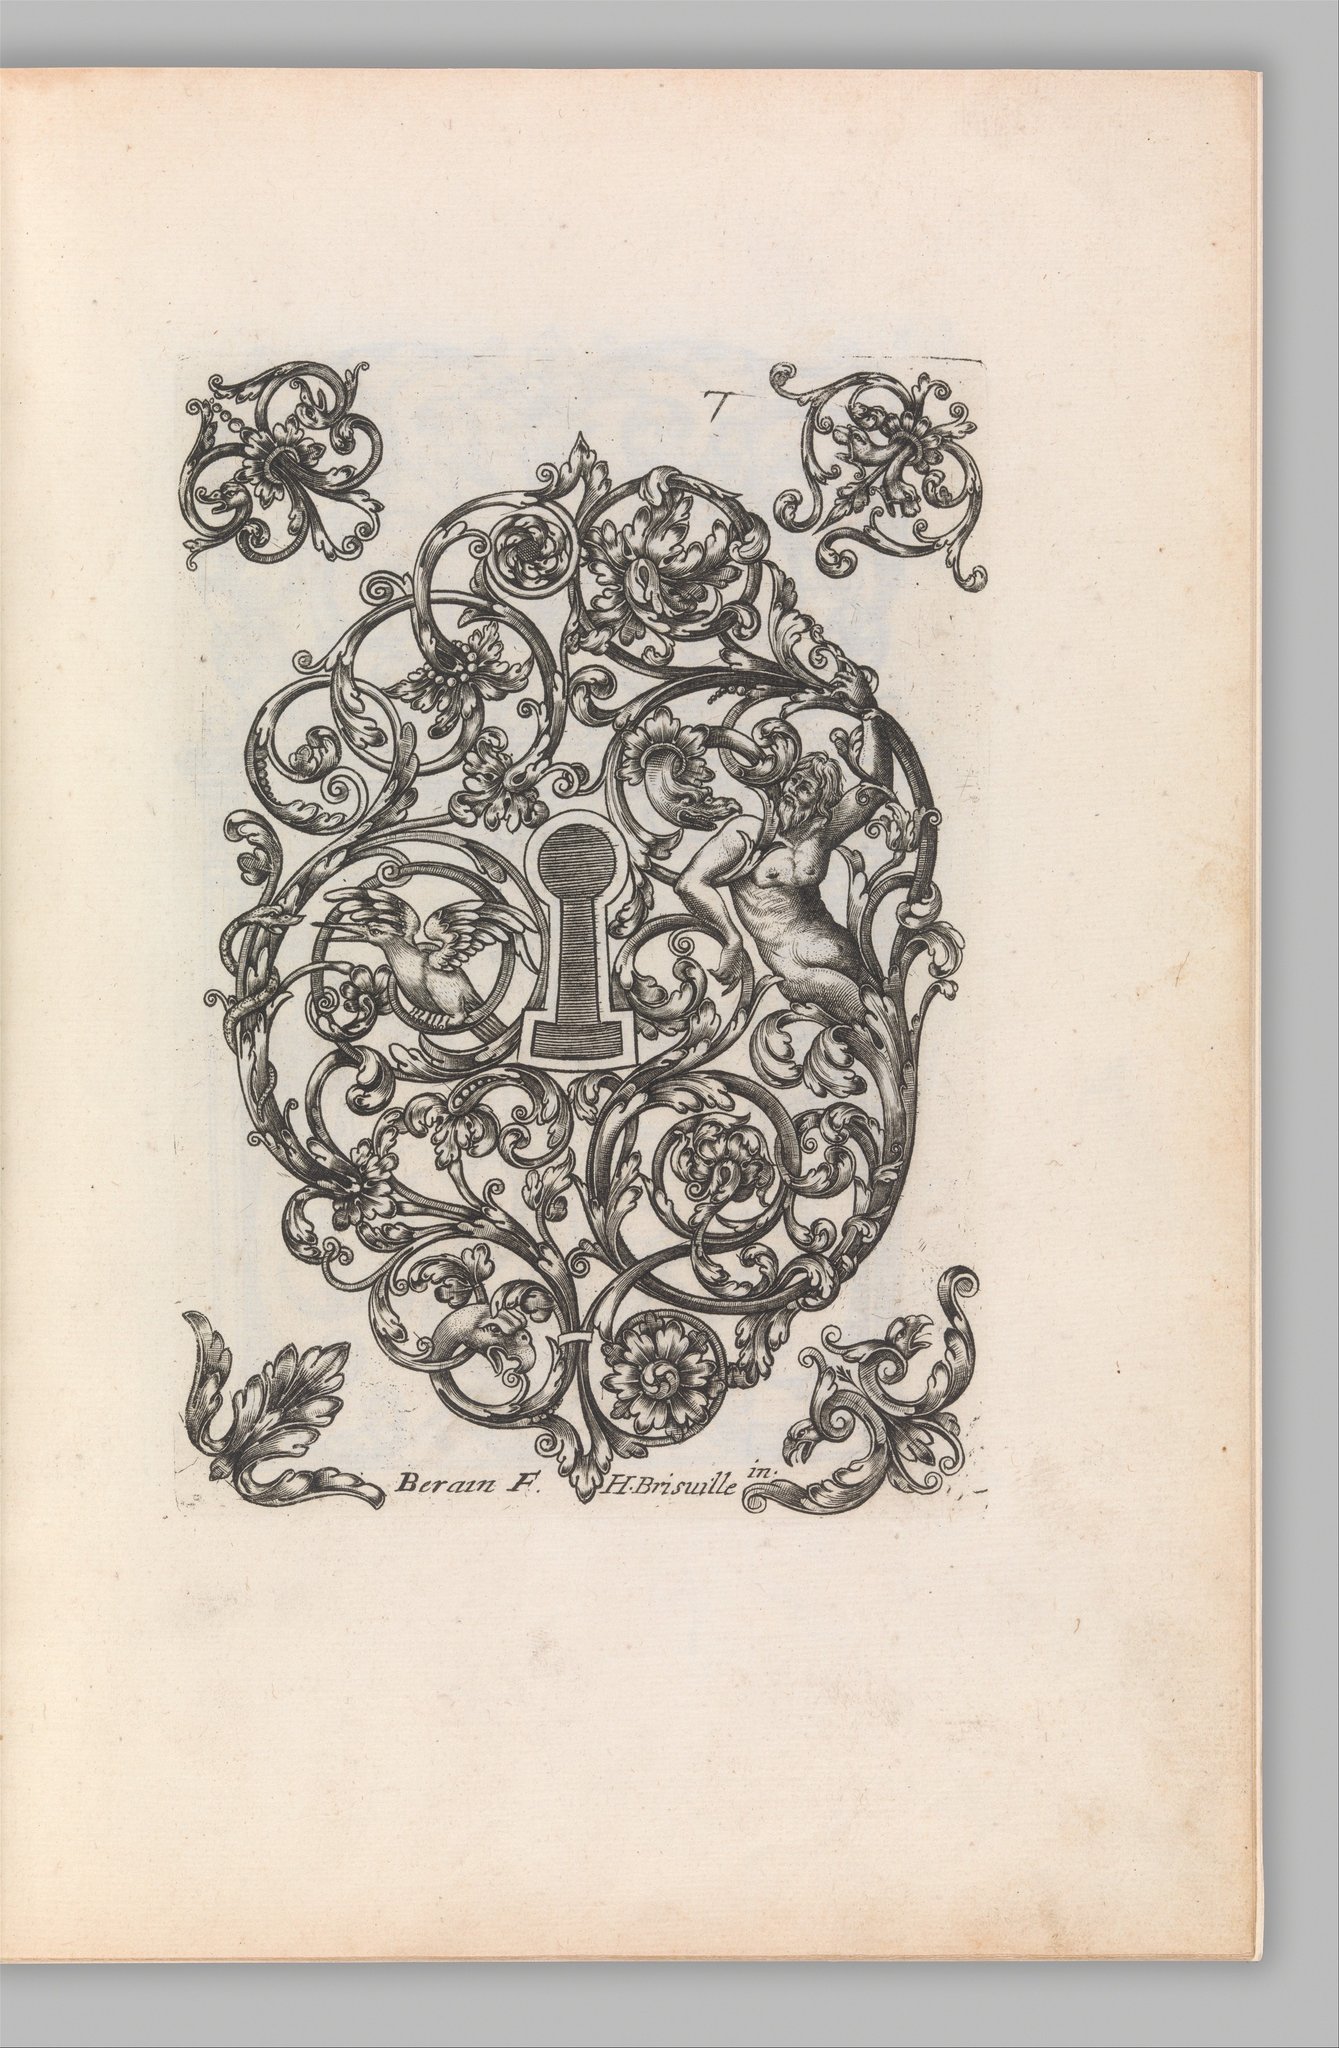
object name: album print ornament architecture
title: Diverses Pieces de Serruriers, page 8 (recto)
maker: jean berain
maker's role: artist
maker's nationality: french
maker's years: 1640-1711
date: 1663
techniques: engraving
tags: birds,male nudes,flowers,acanthus